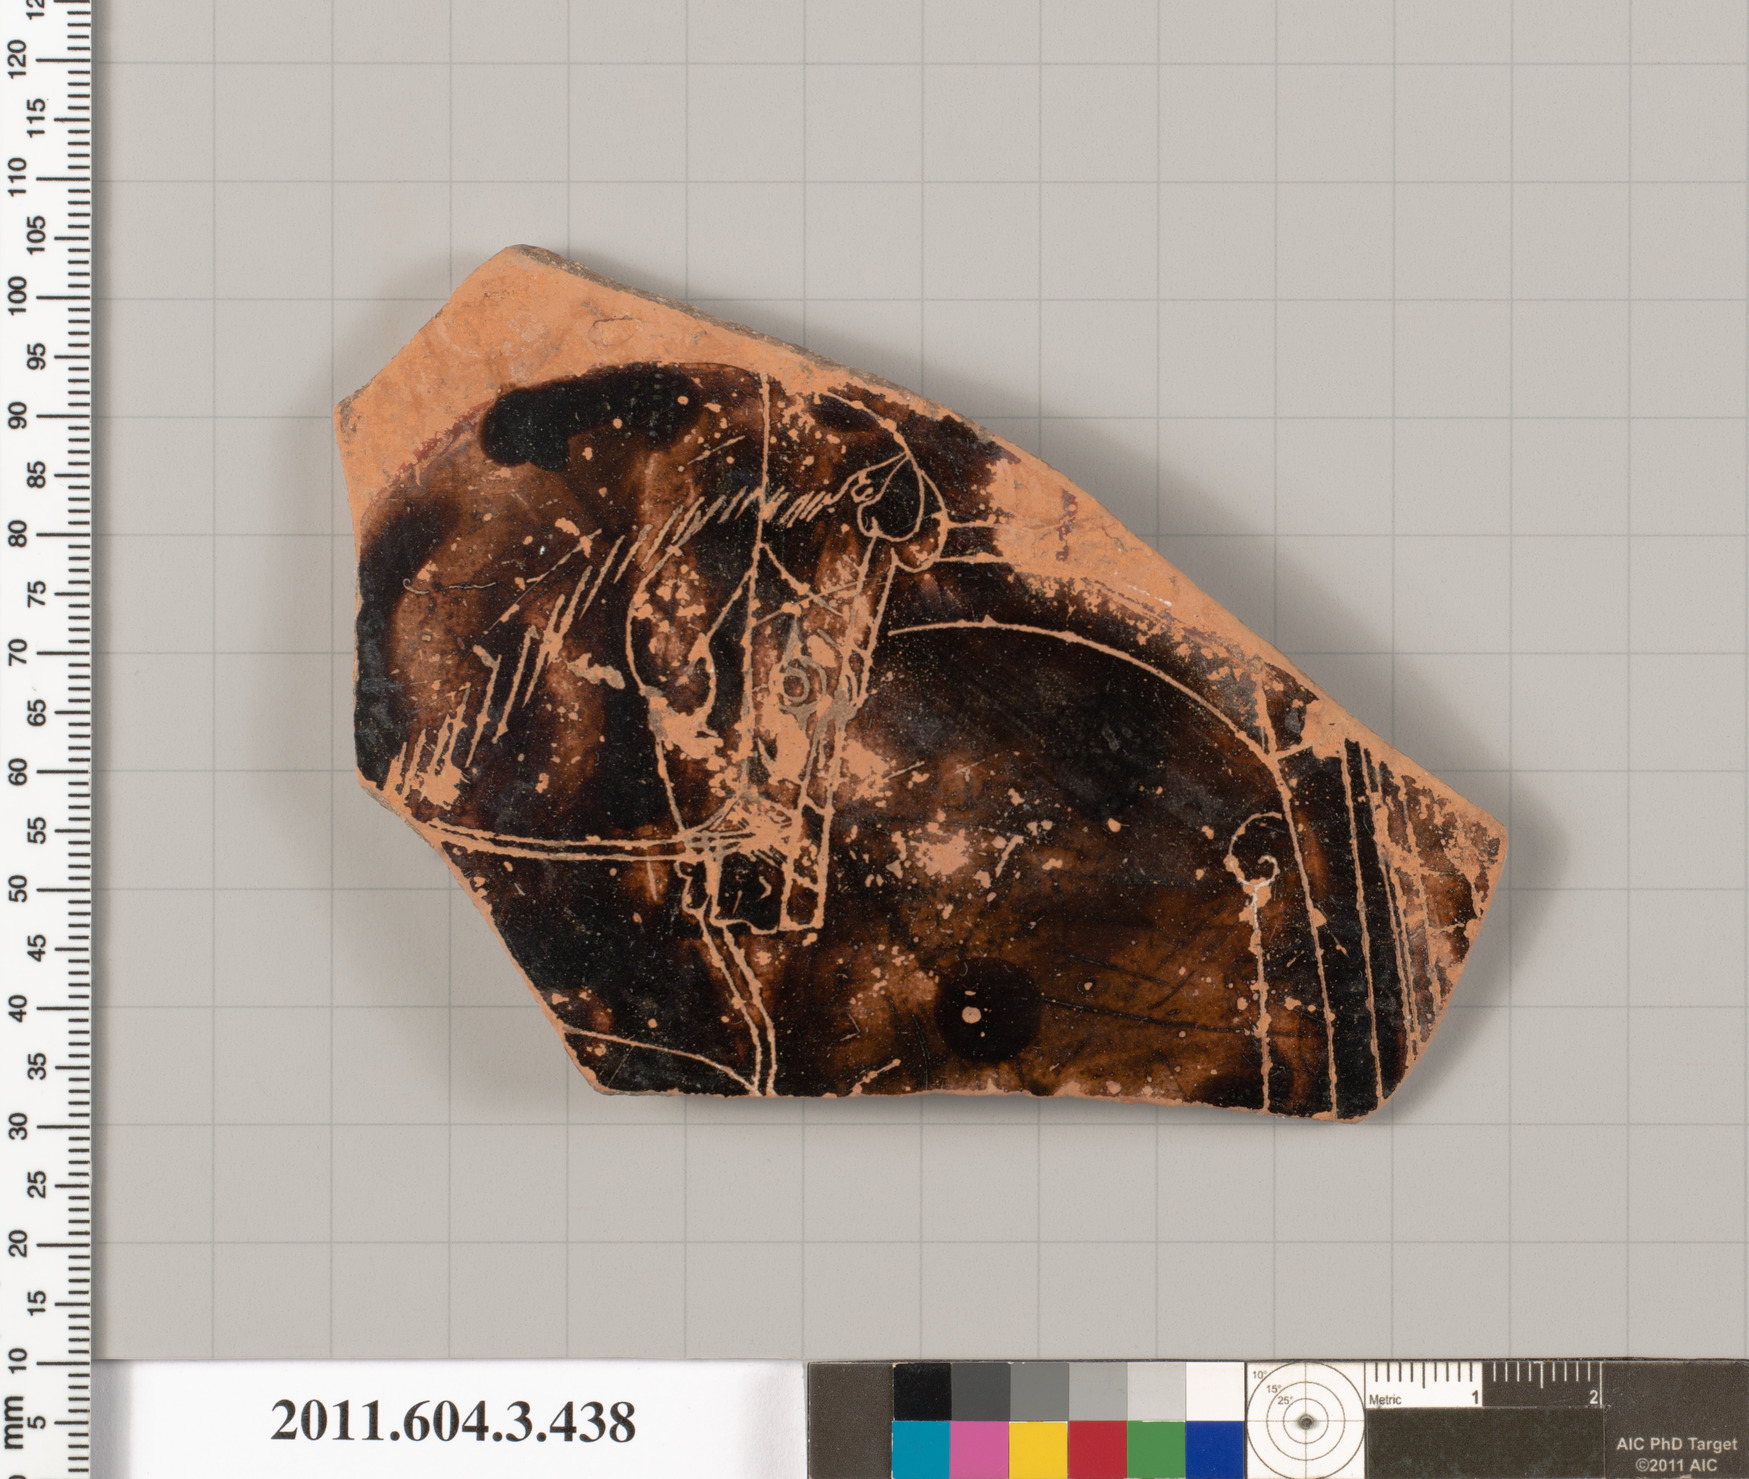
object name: neck amphora fragment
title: Terracotta fragment of a neck-amphora (jar)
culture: greek, attic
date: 520-510 BCE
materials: terracotta